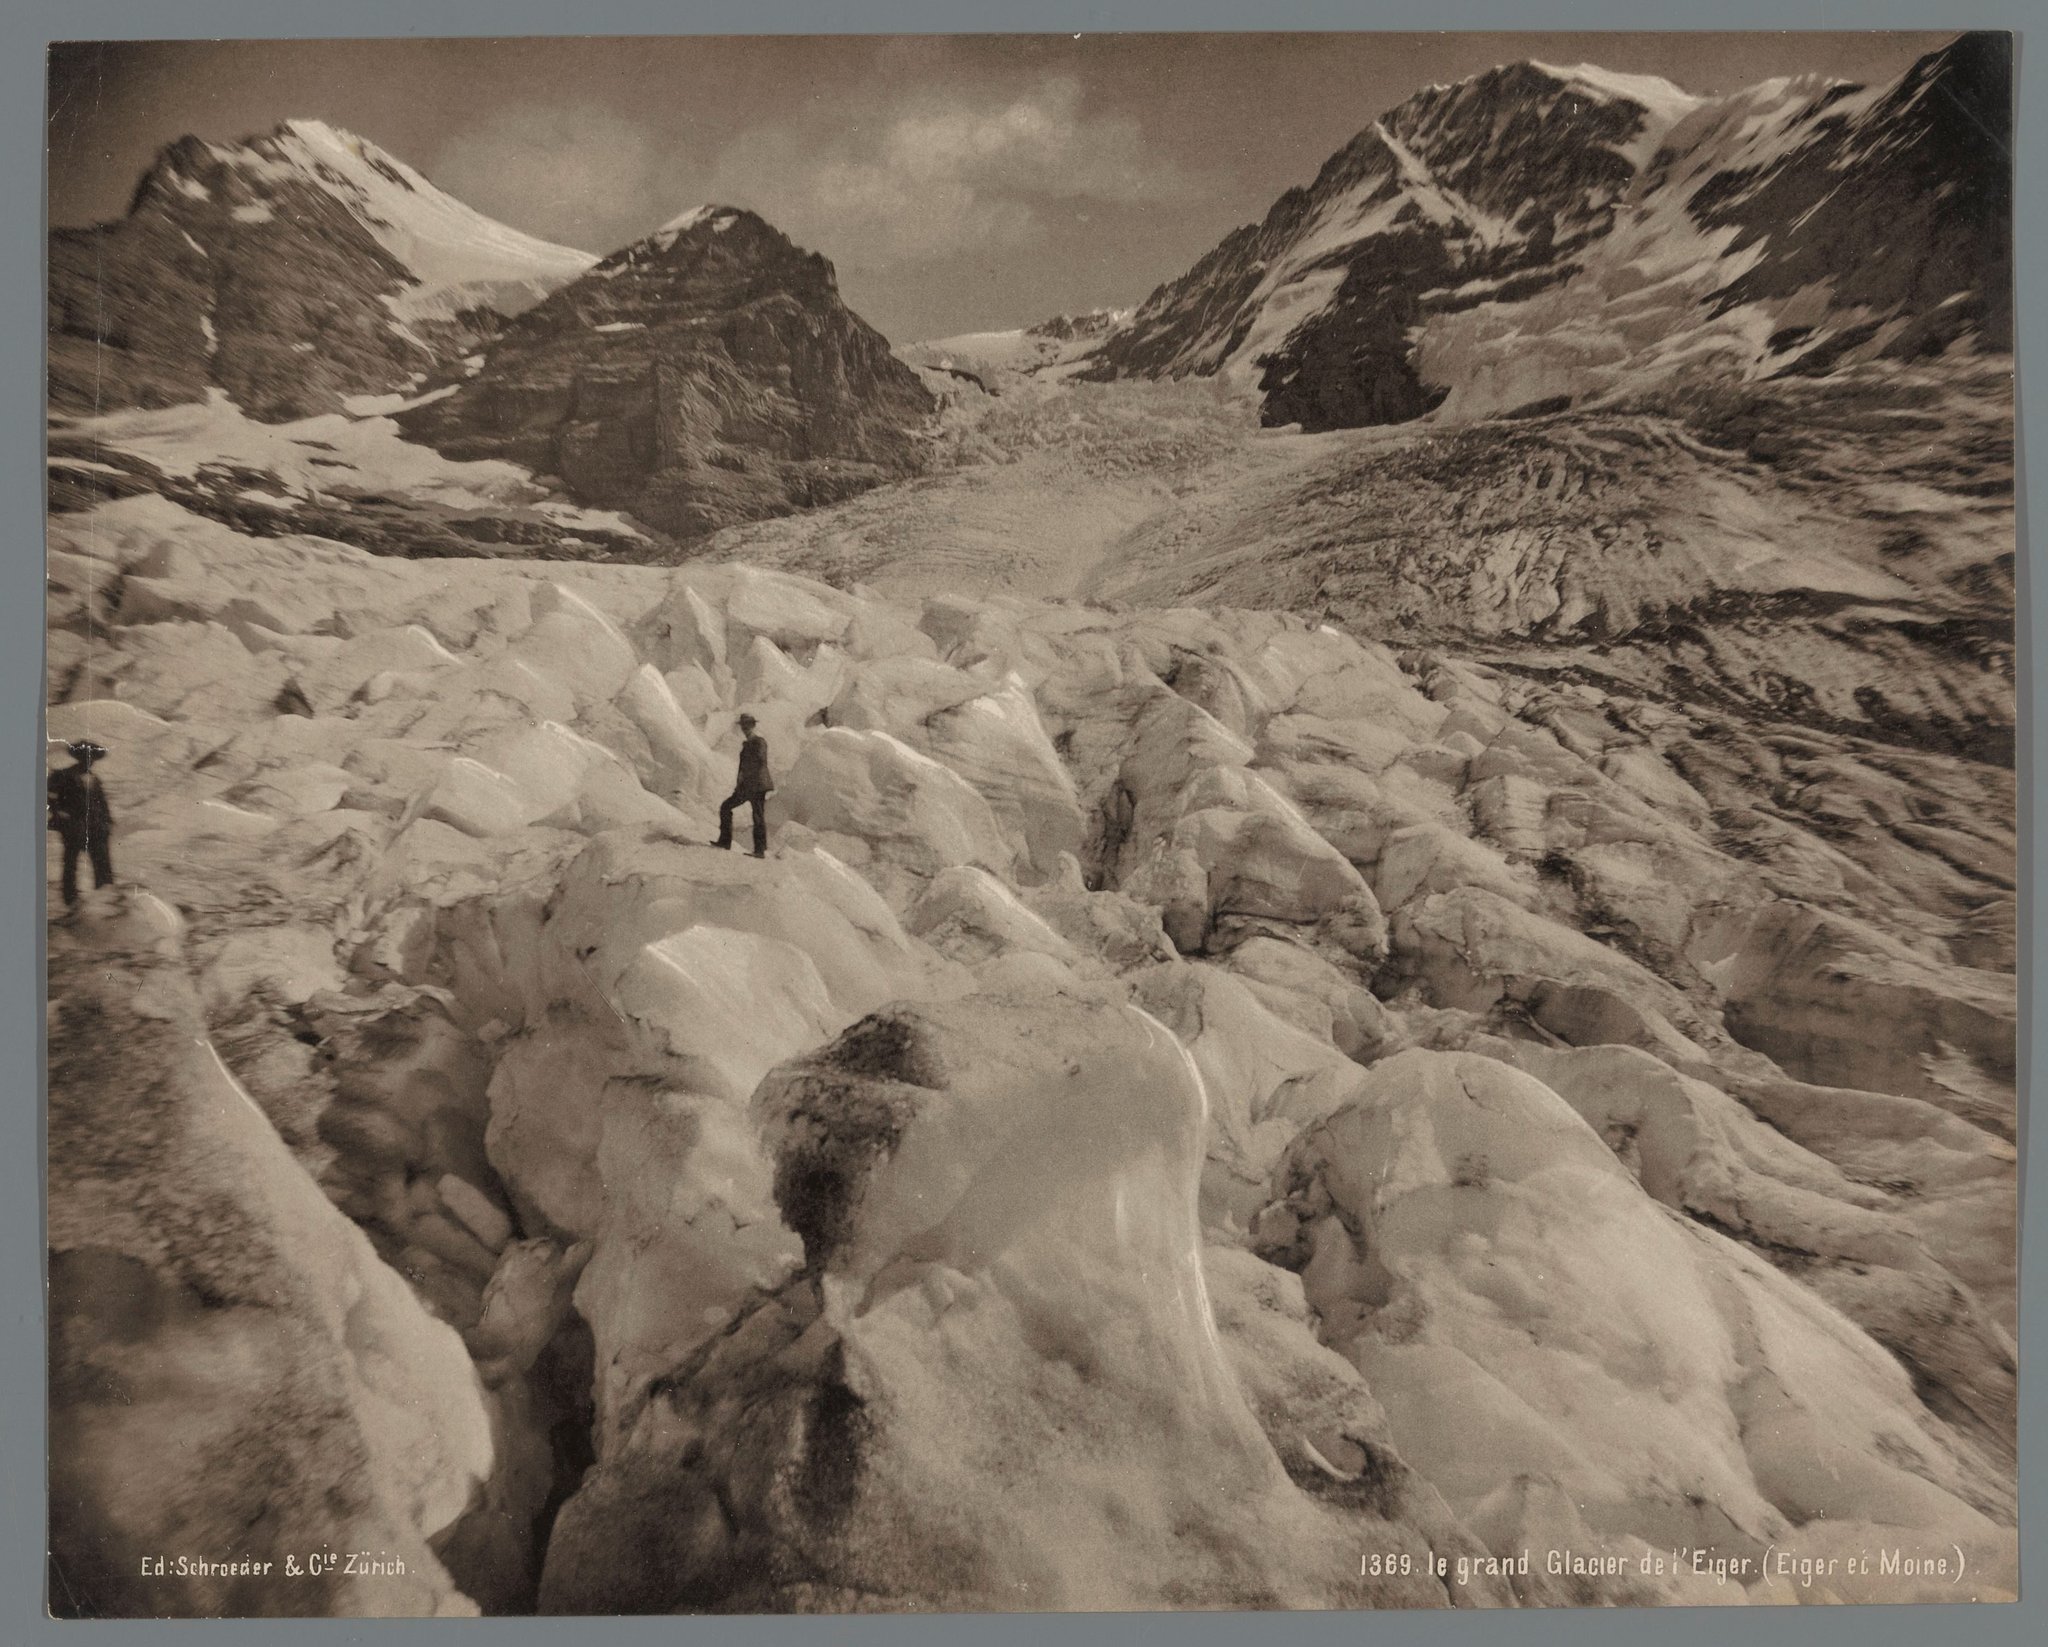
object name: photomechanical print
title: Le grand Glacier de l'Eiger (Eiger et Moine)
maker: Anonymous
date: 1870-1895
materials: paper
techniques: photograph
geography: zurich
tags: glacier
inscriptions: number: ‘1369.’